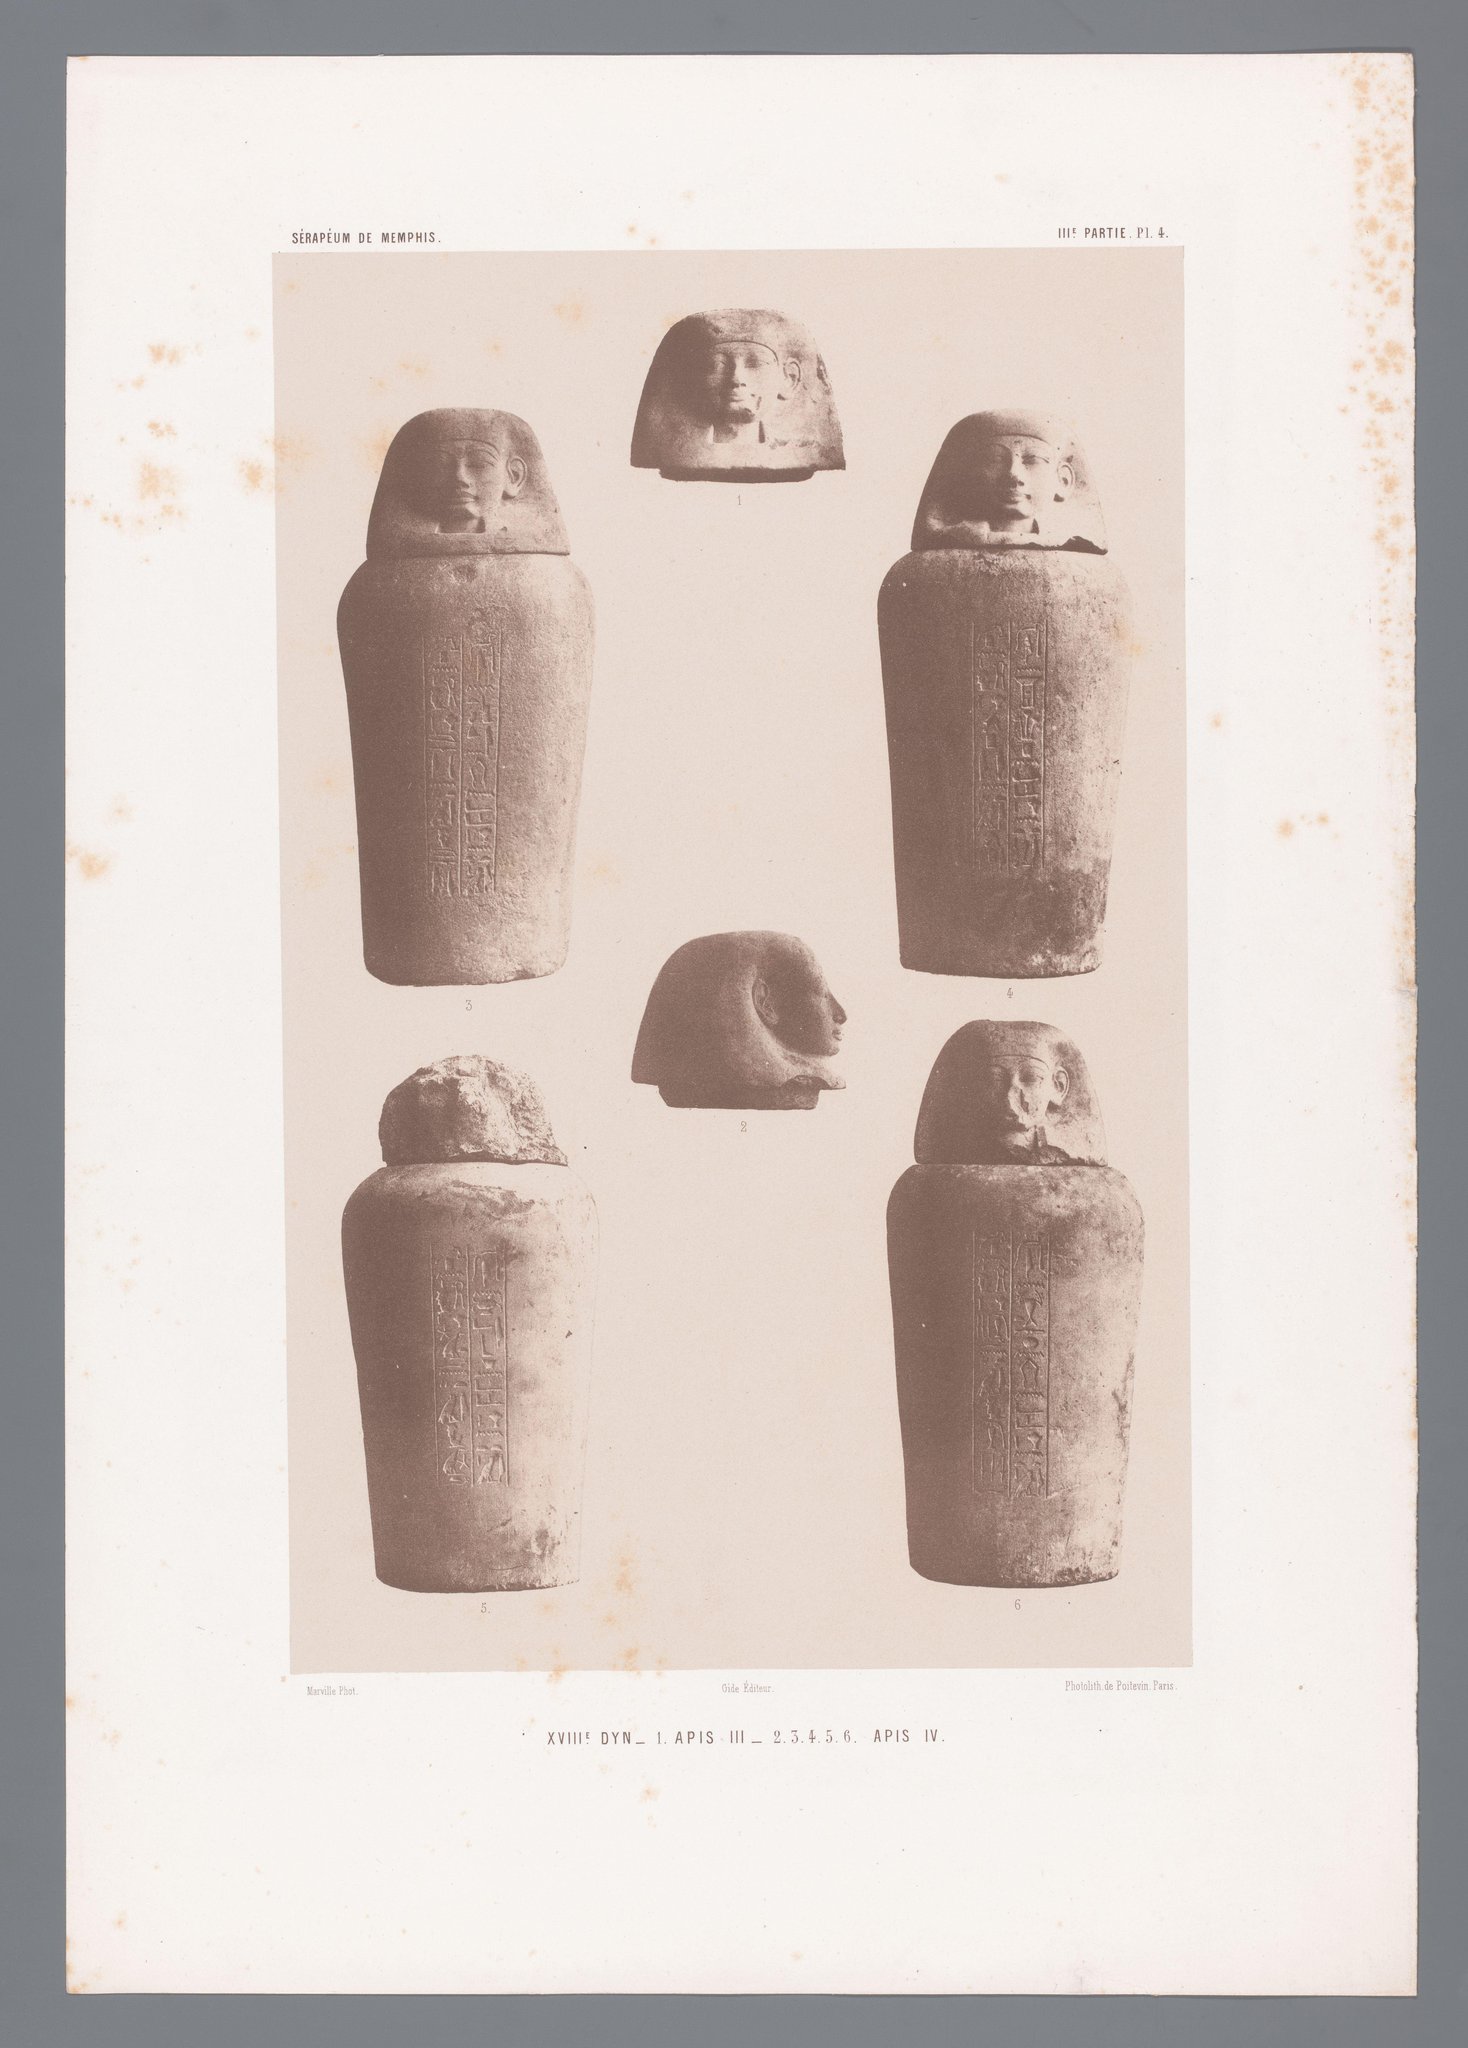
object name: page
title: Vier canopen met de kop van Amset, gevonden bij het Serapeum te Memphis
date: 1852-1857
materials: paper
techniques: photolithography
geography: paris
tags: horus, son of osiris and isis - offspring, companion(s), train, etc. of non-christian god or goddess, ritual practices ~ death and burial (egyptian religion), container of stone: stone vase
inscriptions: inscription: ‘SÉRAPÉU DE MEMPHIS IIIe PARTIE PL.4./ XVIIIe DYN_1. APIS III 2.3.4.5.6. APIS IV.’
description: Deze bladzijde maakt deel uit van een omslag.